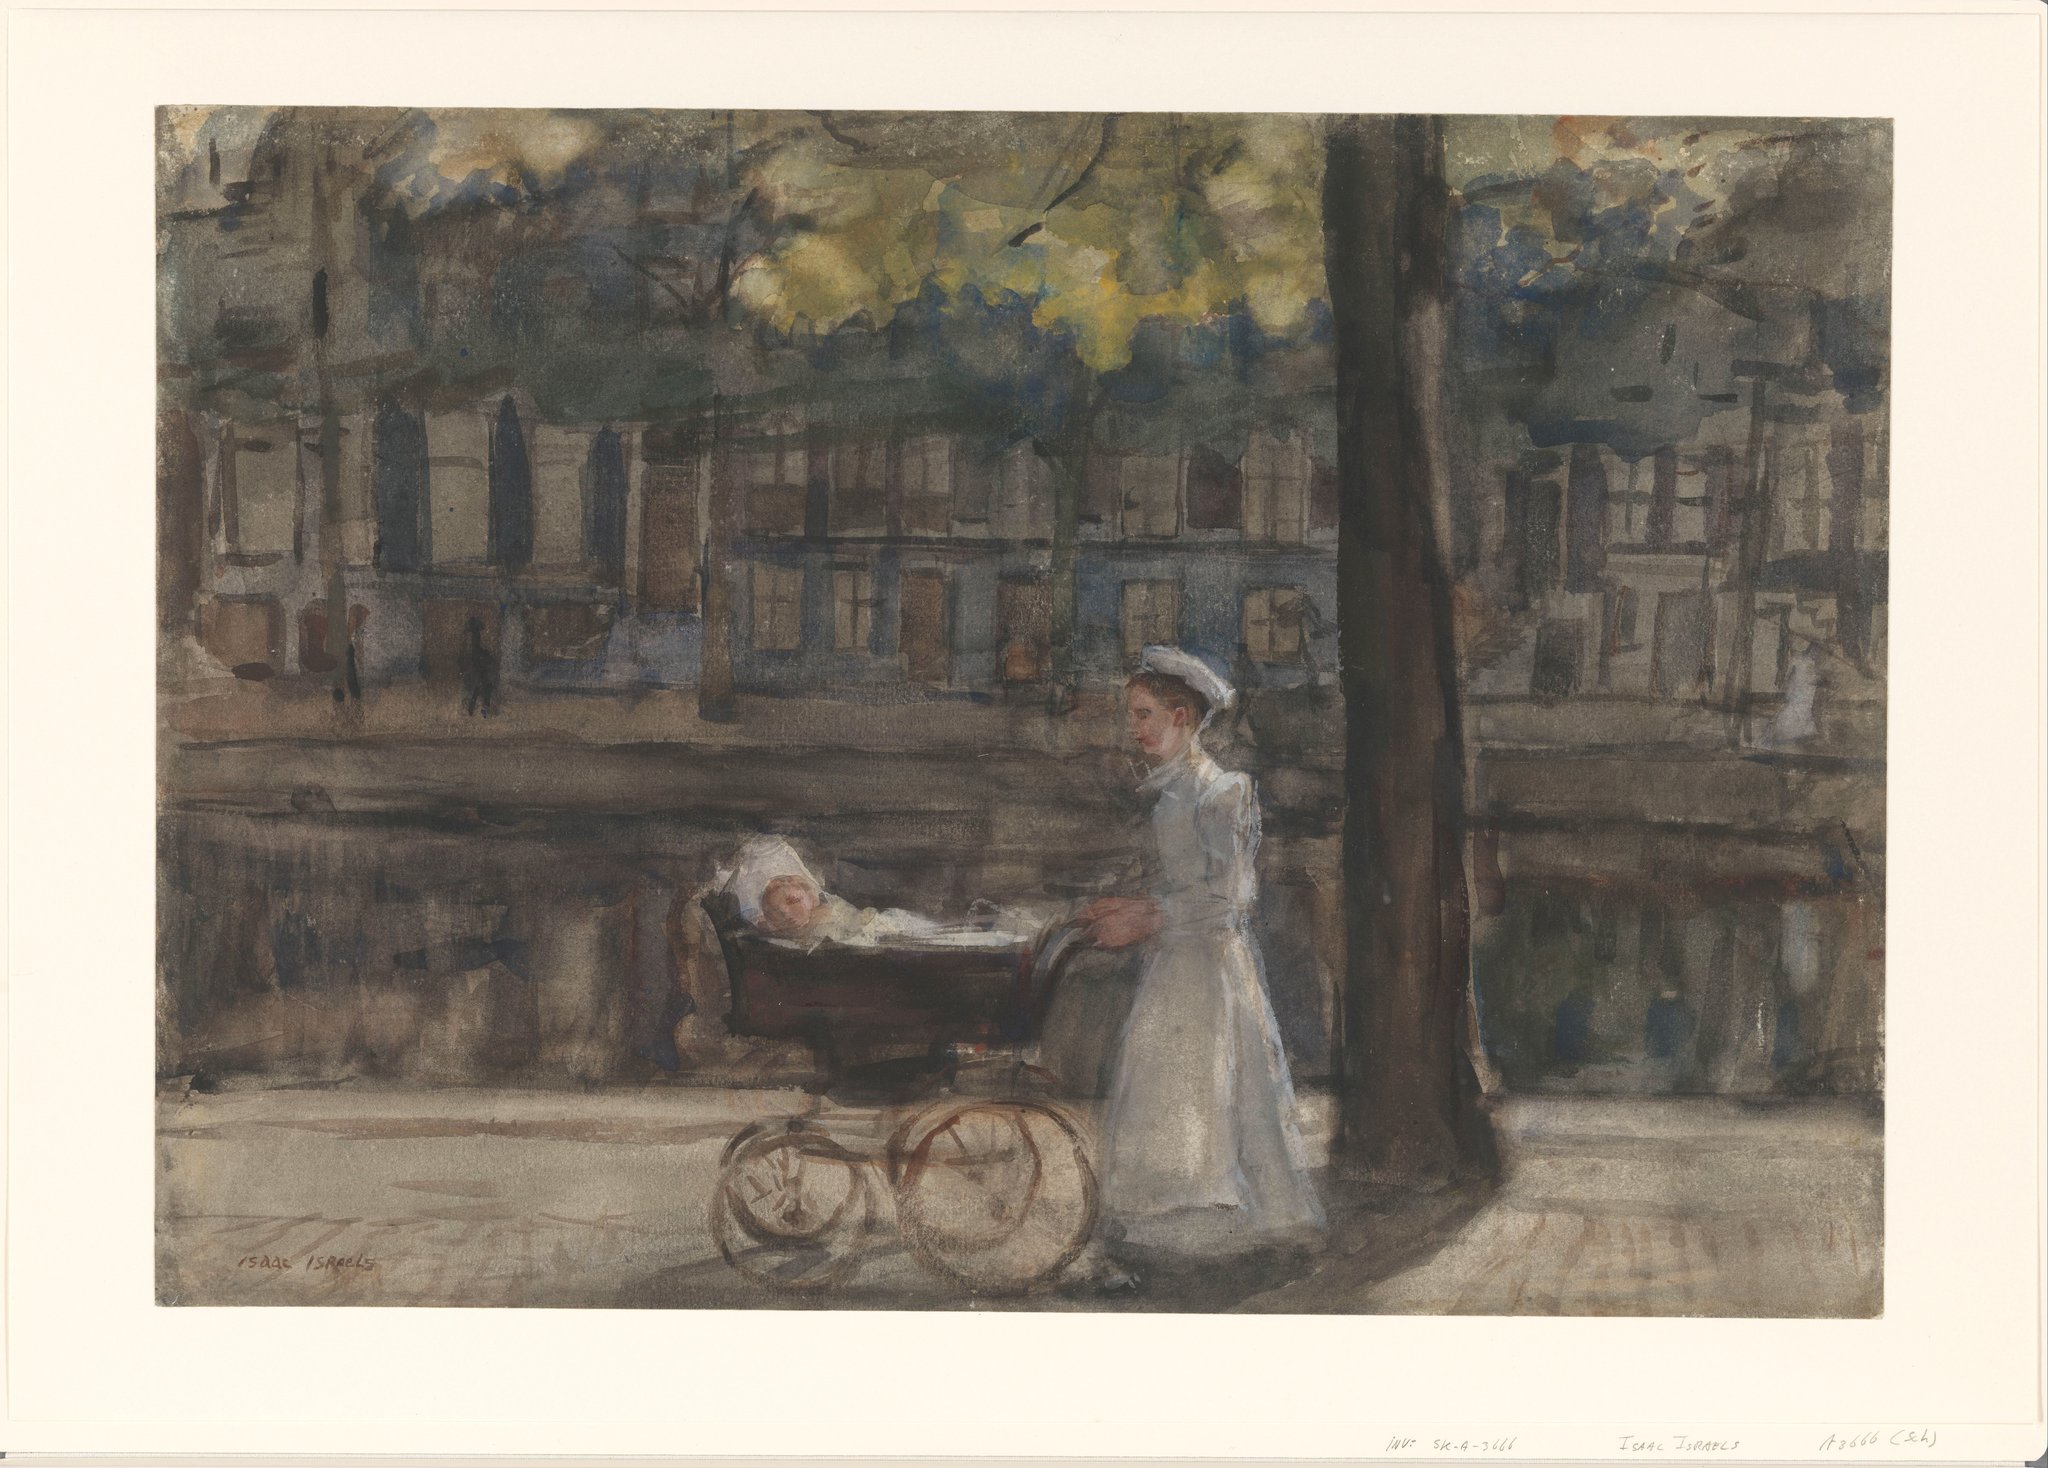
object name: watercolor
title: Dienstmeisje met kinderwagen op de Keizersgracht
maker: isaac israels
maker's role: draughtsman, painter, print maker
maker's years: 1865-1934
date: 1875-1904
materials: paper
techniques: brush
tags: baby-sitter, baby-carriage, pram, perambulator, canals, waters (in city)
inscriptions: signature: ‘Isaac Israels’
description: Dienstmeisje met kinderwagen op de Keizersgracht. Van rechts naar links de nummers 692-704.